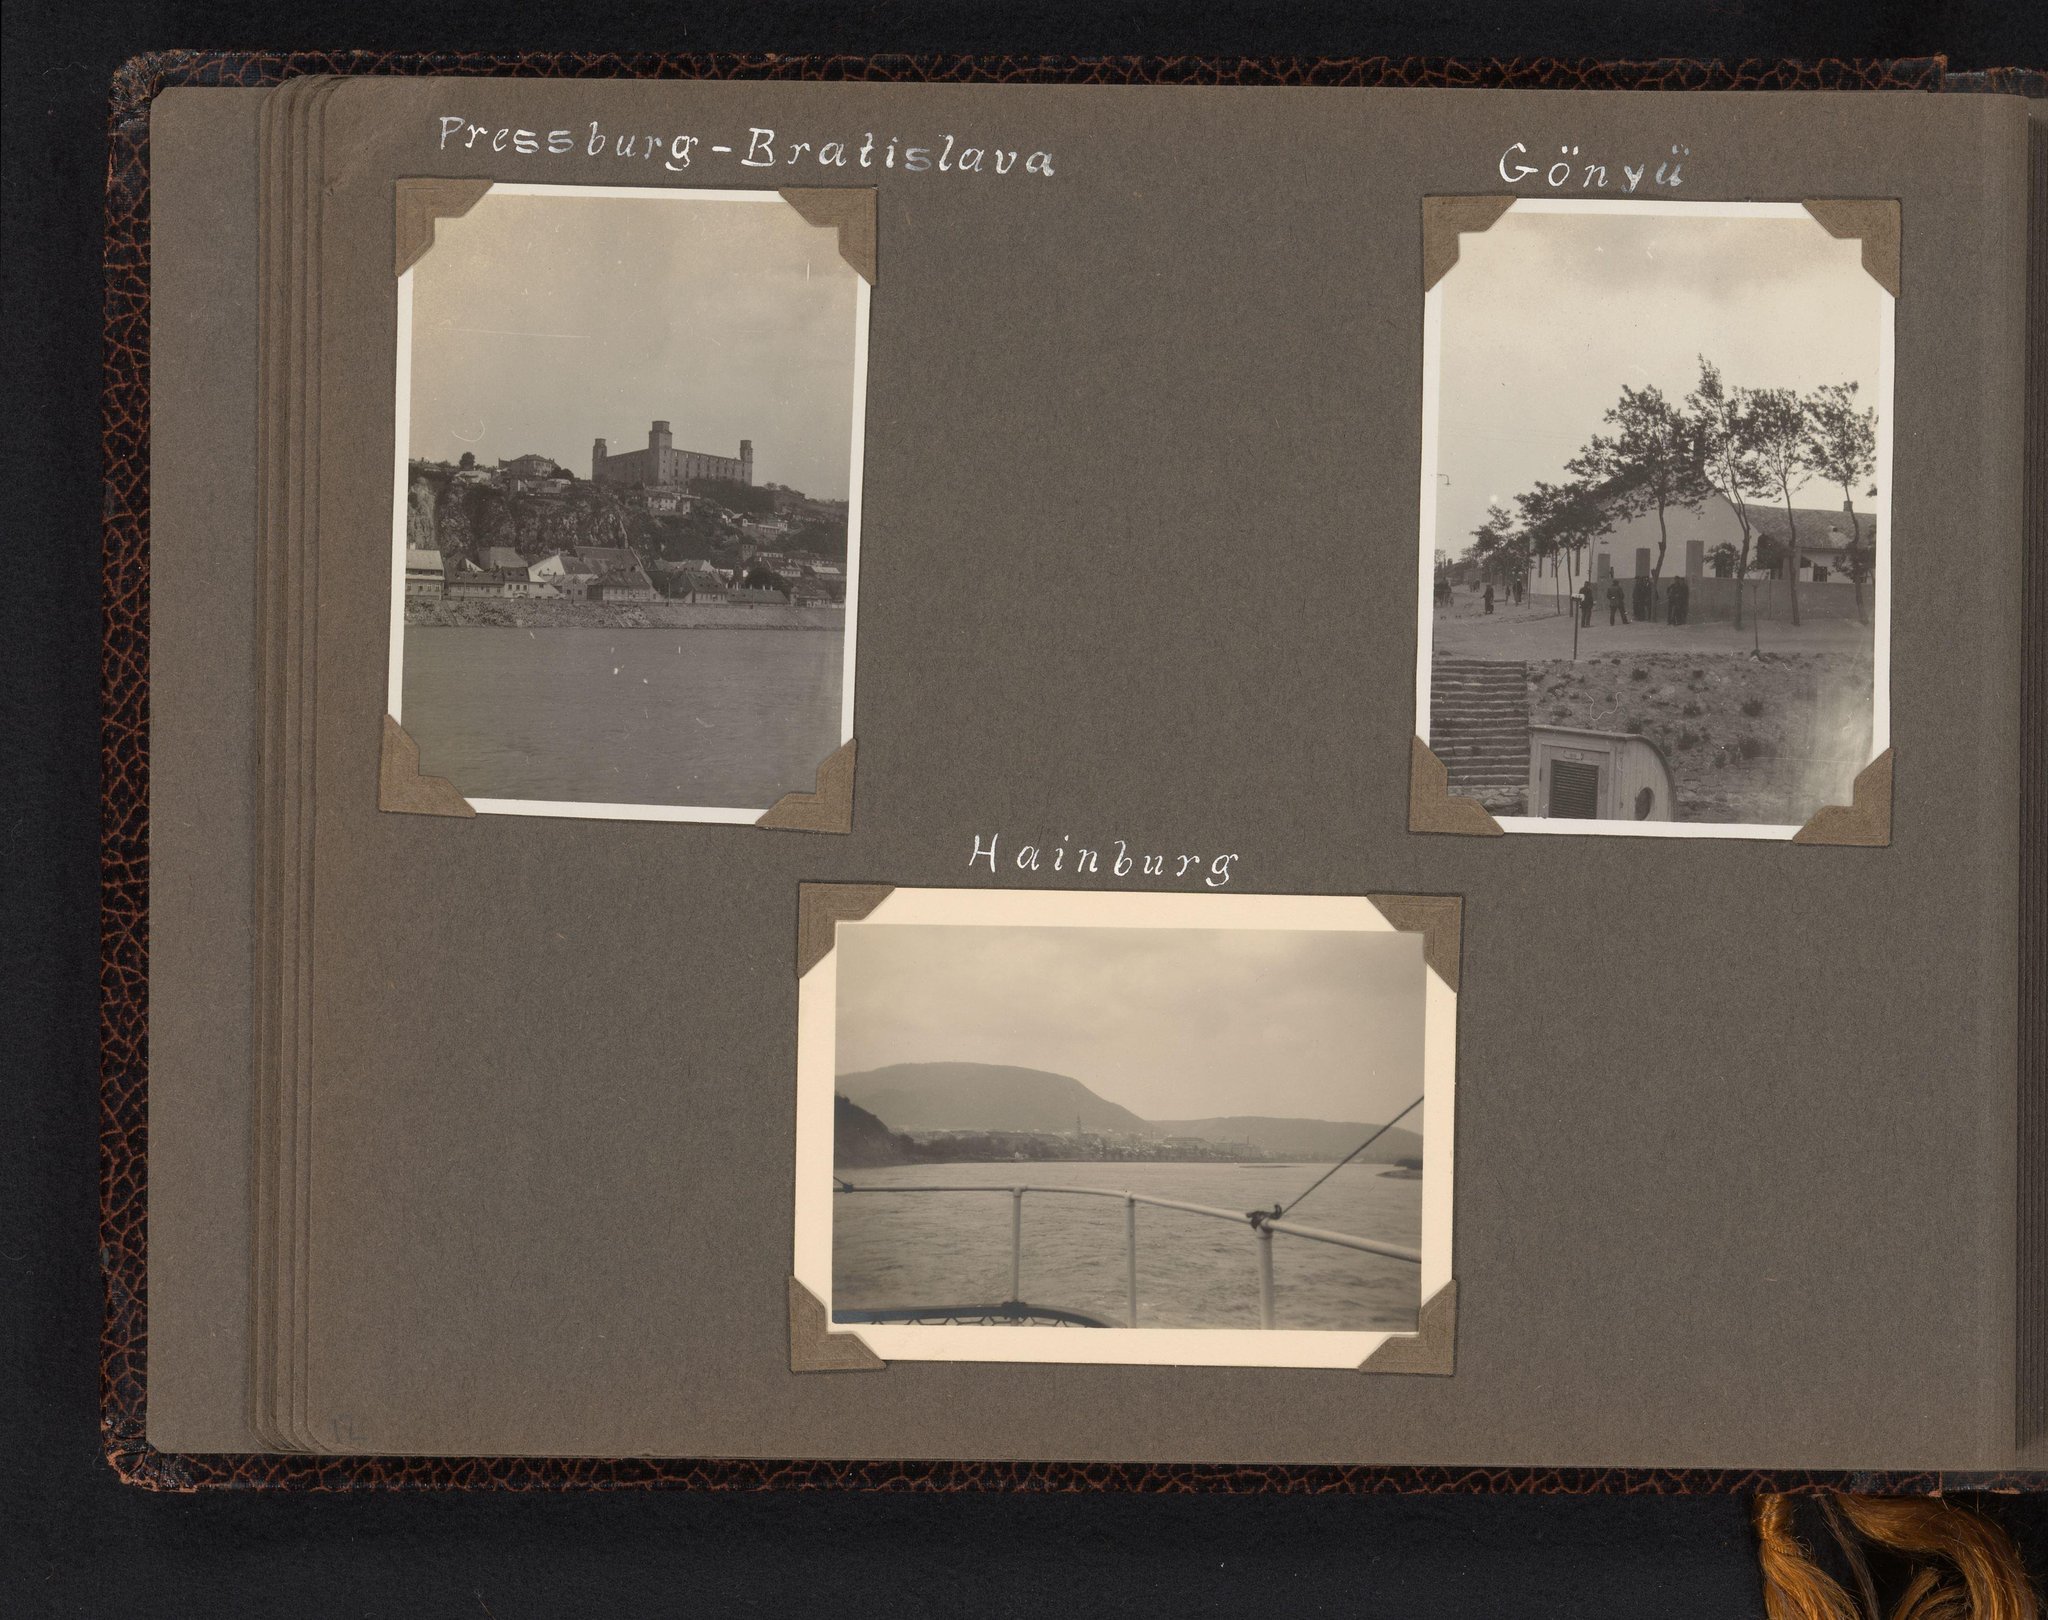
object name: photograph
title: Drie gezichten op Bratislava, Hainburg en Gönyü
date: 1930-1931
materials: cardboard, paper, photographic support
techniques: gelatin silver print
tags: city-view in general; 'veduta', river, historical persons - bb - woman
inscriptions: annotation: ‘Pressburg-Bratislava/ Hainburg/ Gönyü’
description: Drie foto's gemaakt tijdens hun boottocht over de Donau. Deze pagina maakt deel uit van een album.